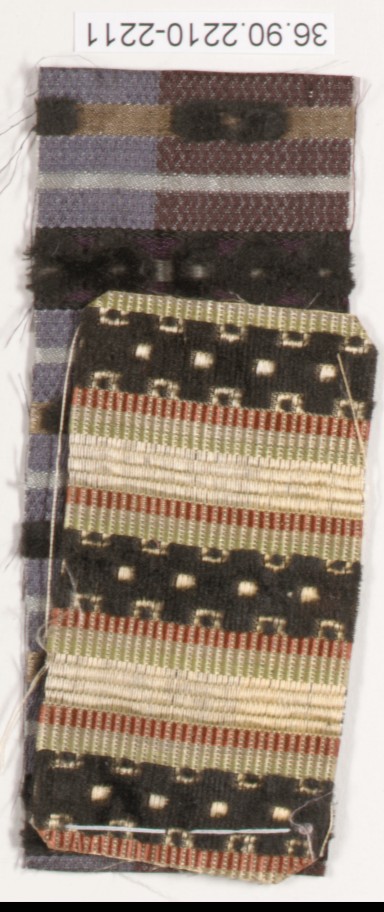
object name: piece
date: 1801-1900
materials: silk